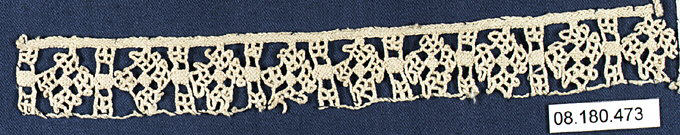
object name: border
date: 1601-1700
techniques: lace